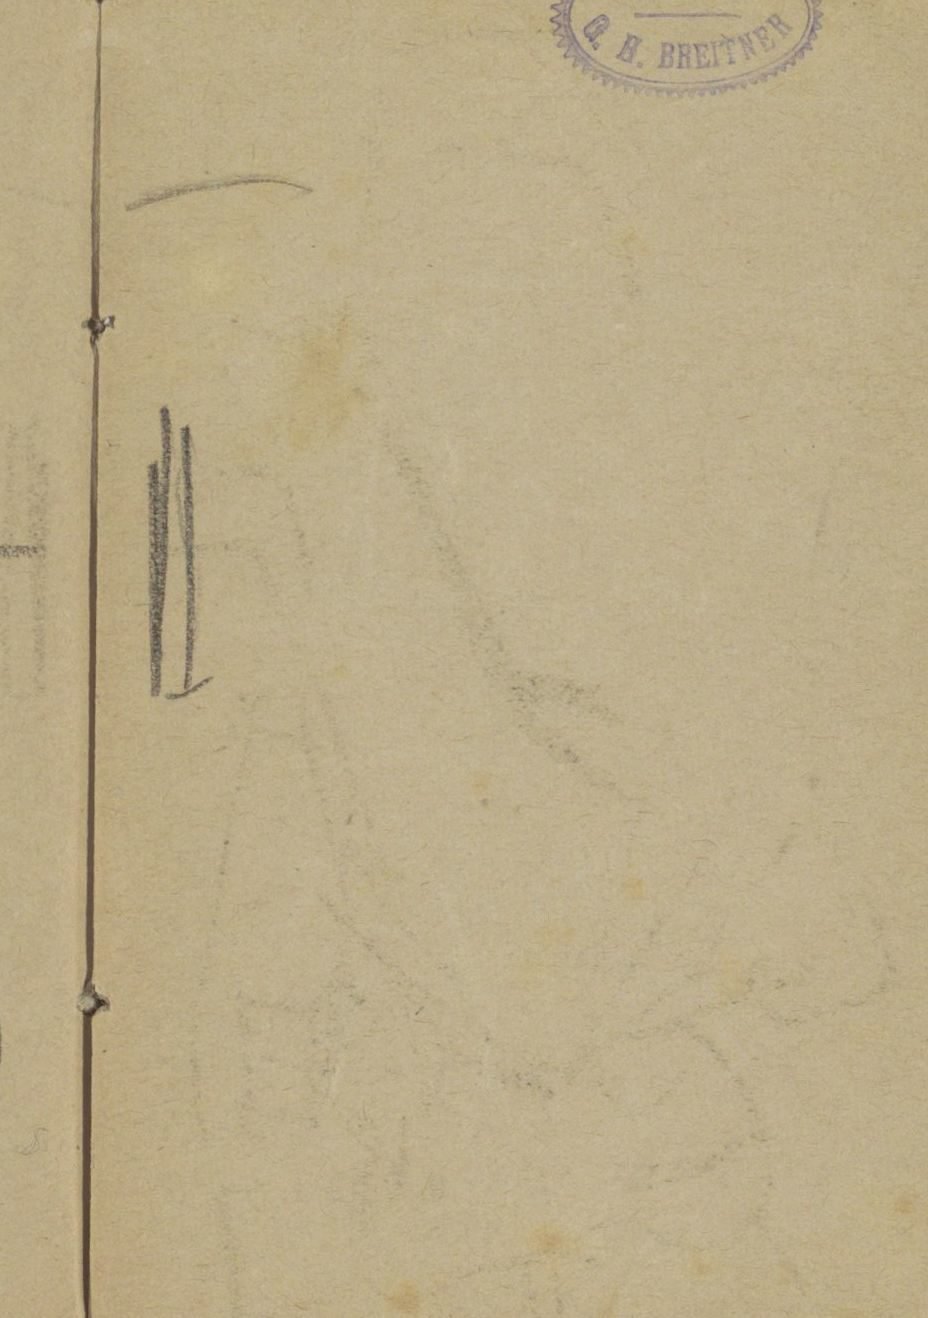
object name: sketchbook leaf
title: Studie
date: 1887-1891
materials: chalk, paper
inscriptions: workshop stamp: Lugt 291d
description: Pagina 92 uit een schetsboek met 83 bladen.